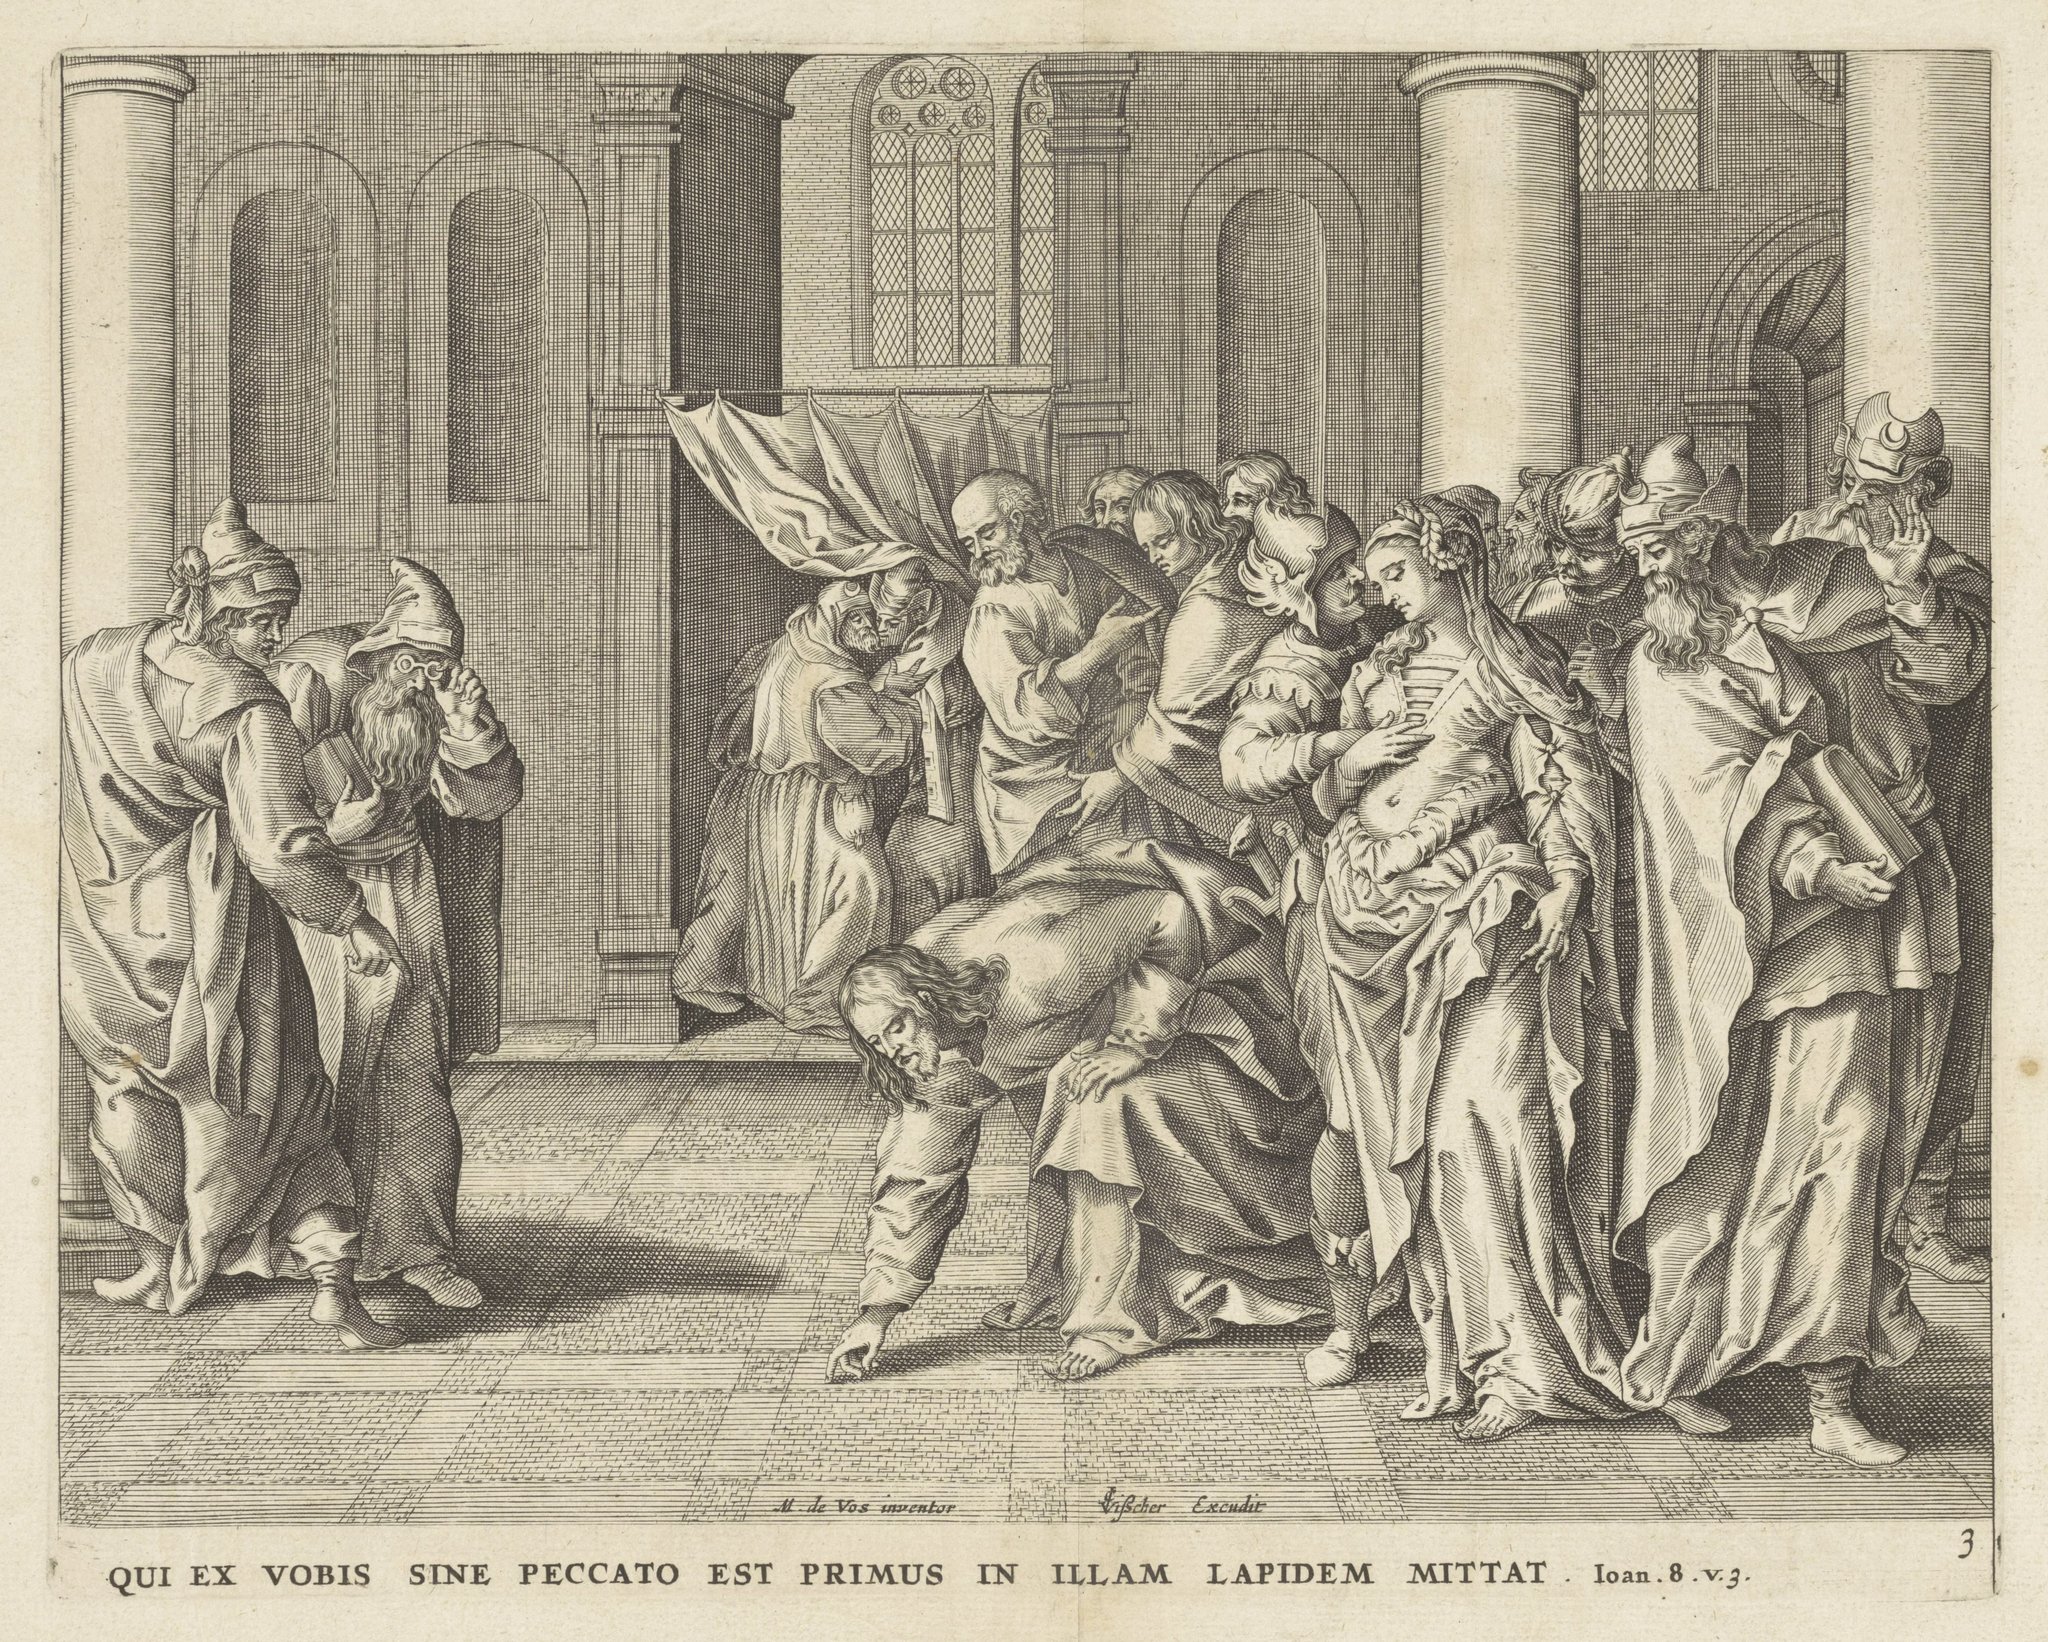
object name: print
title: Theatrum biblicum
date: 1643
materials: paper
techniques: engraving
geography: amsterdam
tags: christ points to or writes on the ground, pharisees bring a woman accused of adultery before christ (john 8:2-11)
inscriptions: collector's mark: Lugt 2228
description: In de tempel brengen farizeeën een vrouw die op overspel betrapt is bij Christus. De farizeeën vragen wat Christus vindt van de wet van Mozes waarin staat dat zulke vrouwen moeten worden gestenigd. Christus schrijft met zijn vinger op de grond: degene die zonder zonde is moet de eerste steen maar werpen. Onder de voorstelling een verwijzing in het Latijn naar de Bijbeltekst in Joh. 8:3.